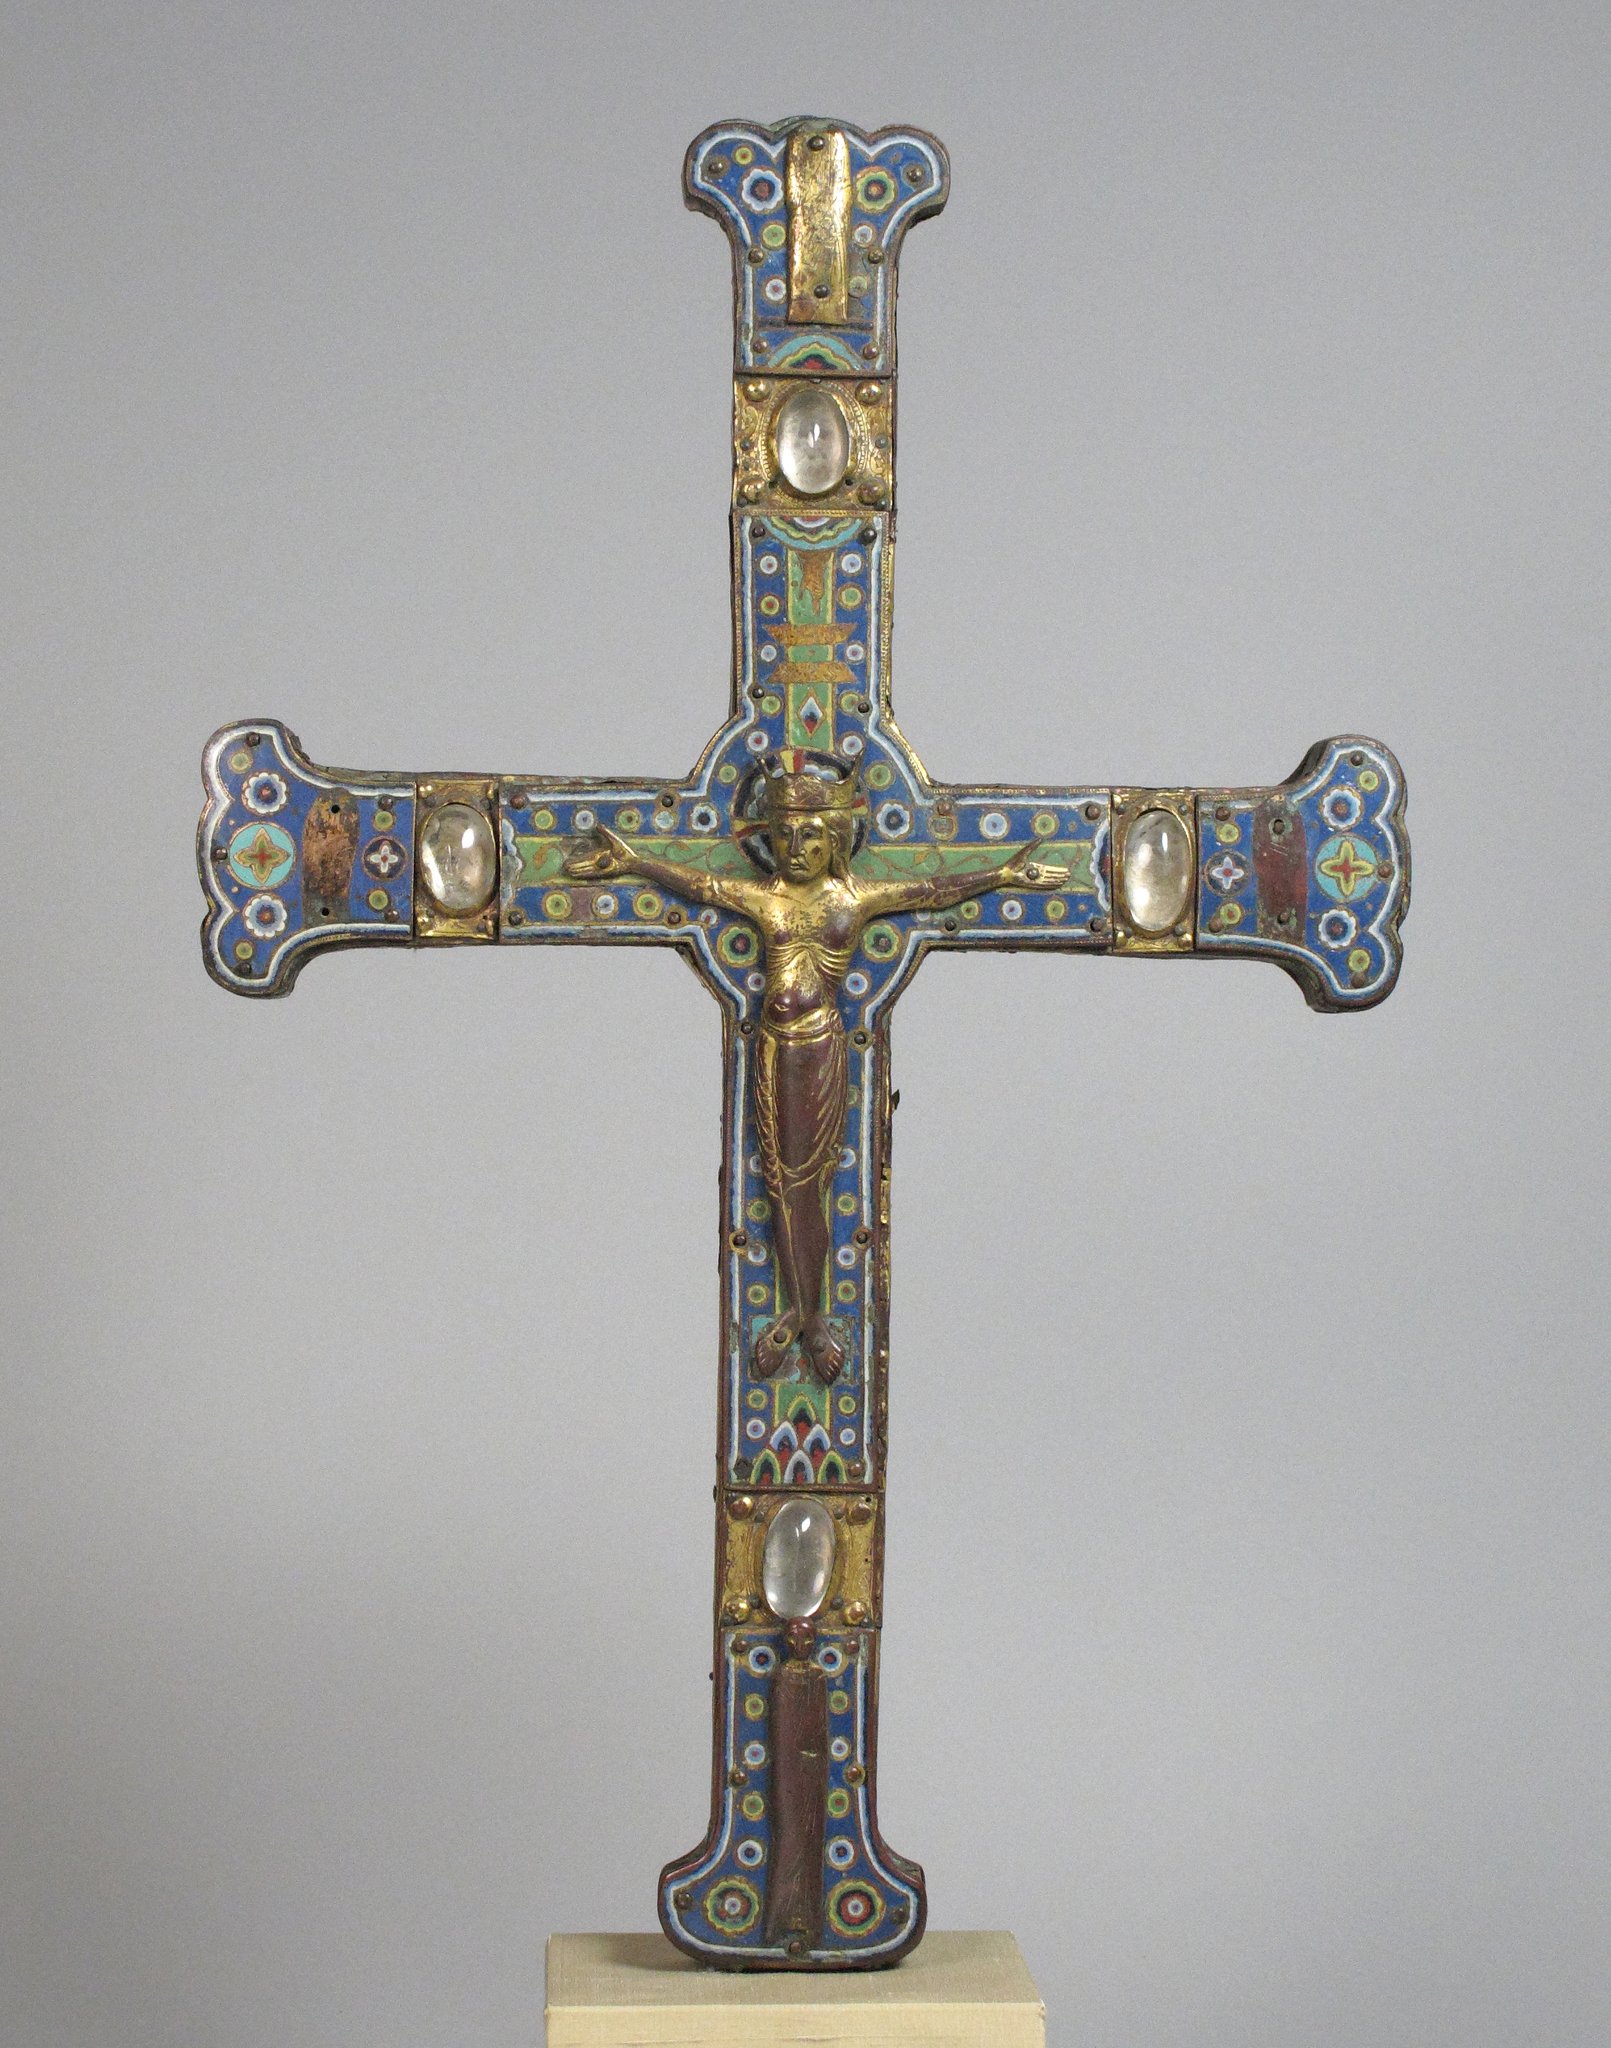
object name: cross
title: Processional Cross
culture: french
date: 1201-1300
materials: enamel, copper gilt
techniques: enamel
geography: france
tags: christ